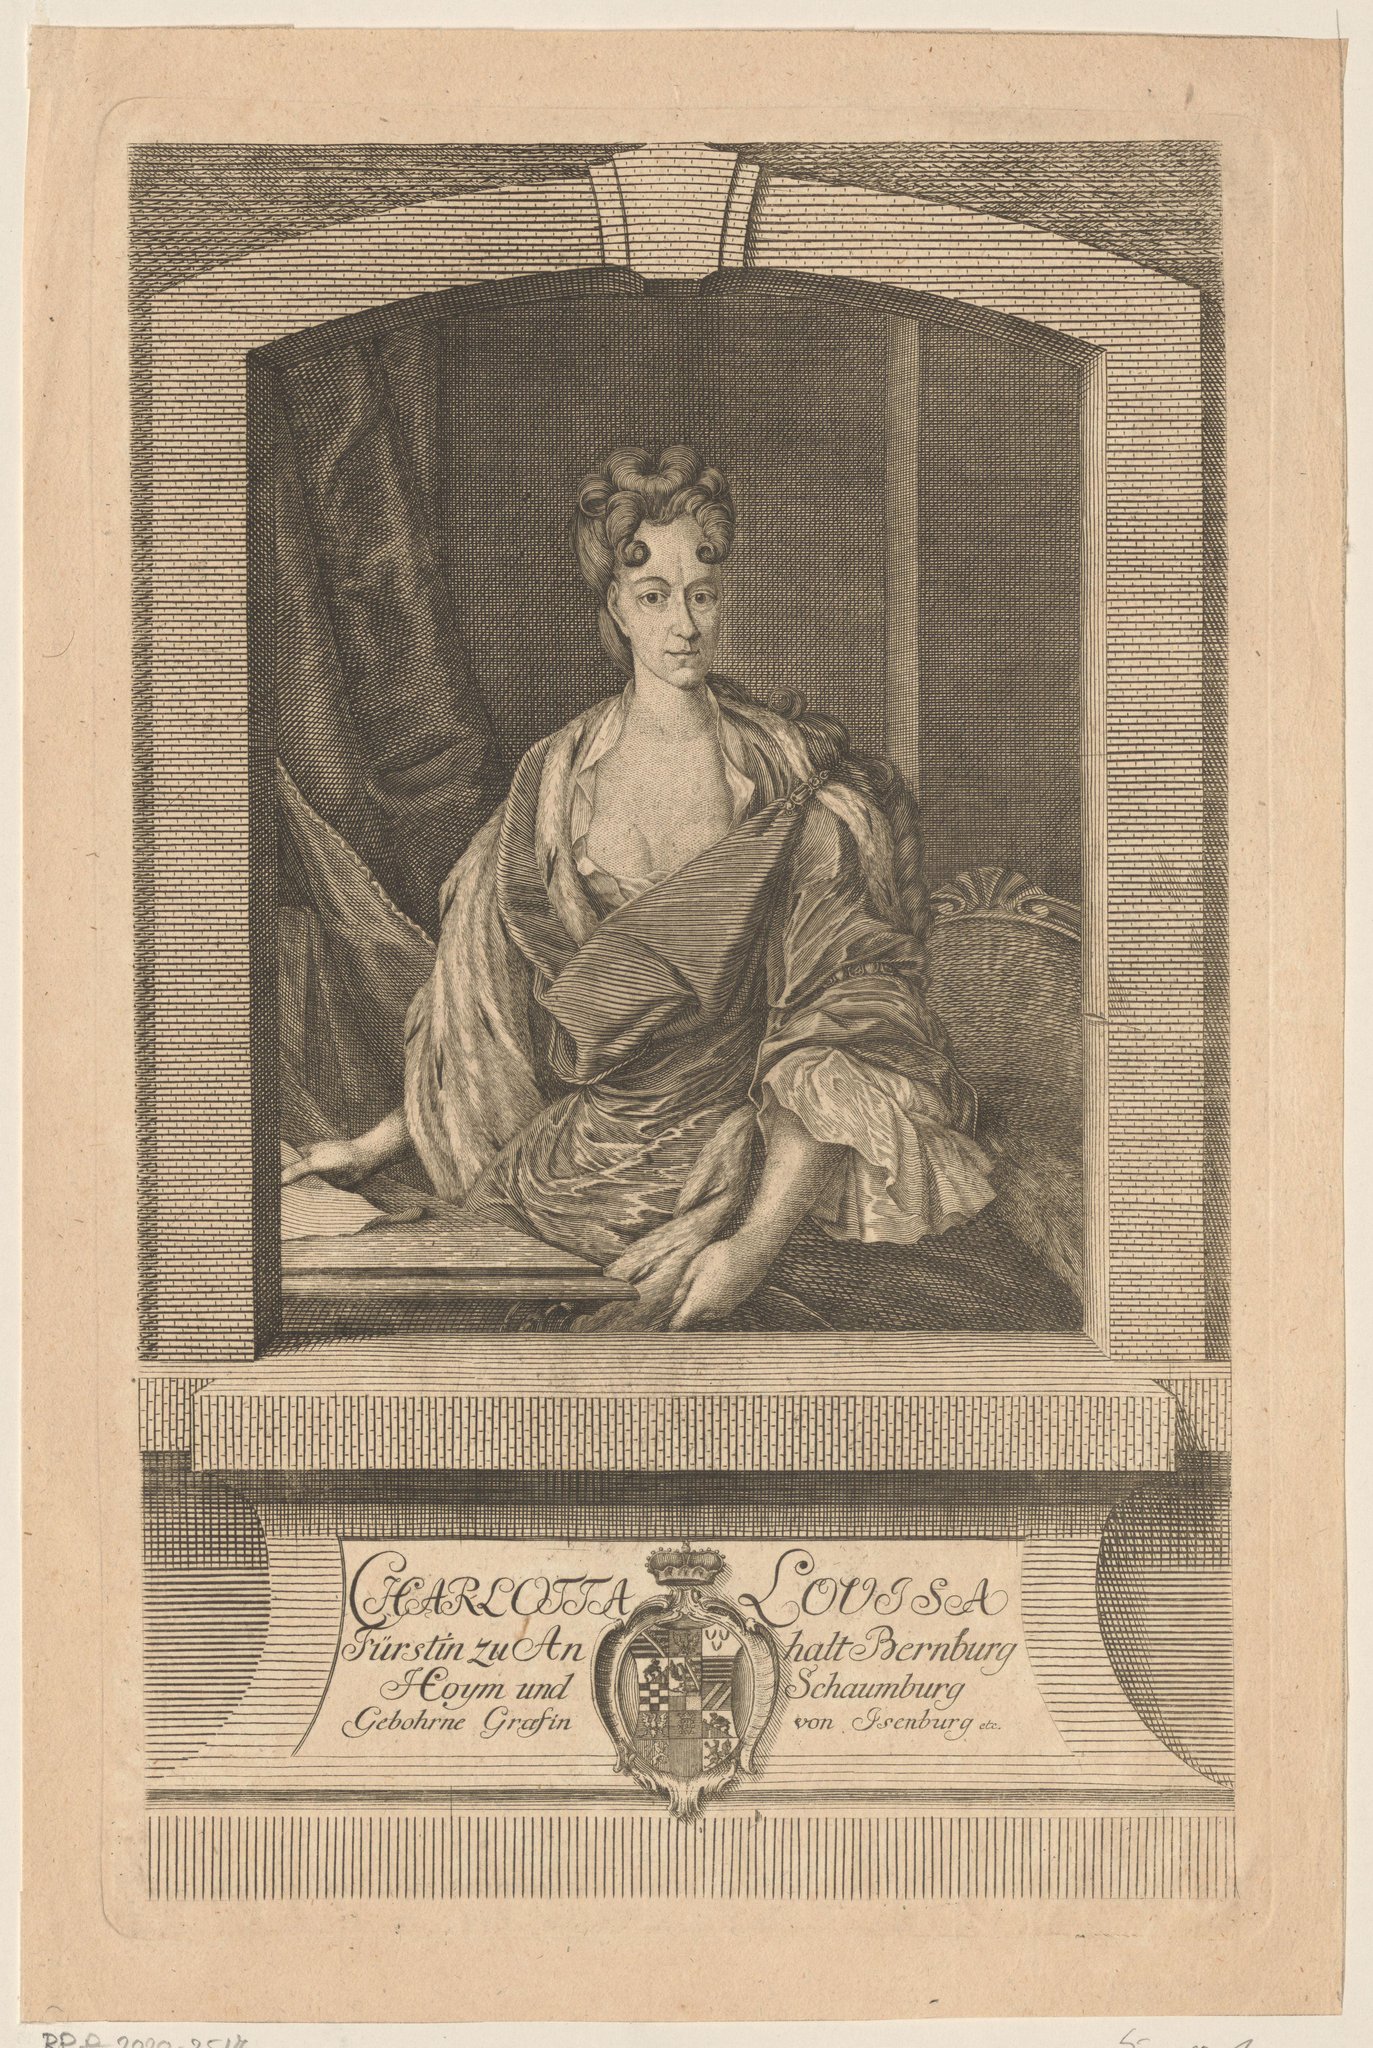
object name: print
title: Portret van Charlotte Louise van Isenburg-Büdingen-Birstein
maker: johann christoph sysang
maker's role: print maker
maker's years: 1703-1757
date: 1757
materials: paper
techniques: etching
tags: historical persons - bb - woman, armorial bearing, heraldry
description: Prent mogelijk uit: Beckmann, Johann Christian. Historie des Fürstenhauses Anhalt. Zerbst: s.n., 1757.